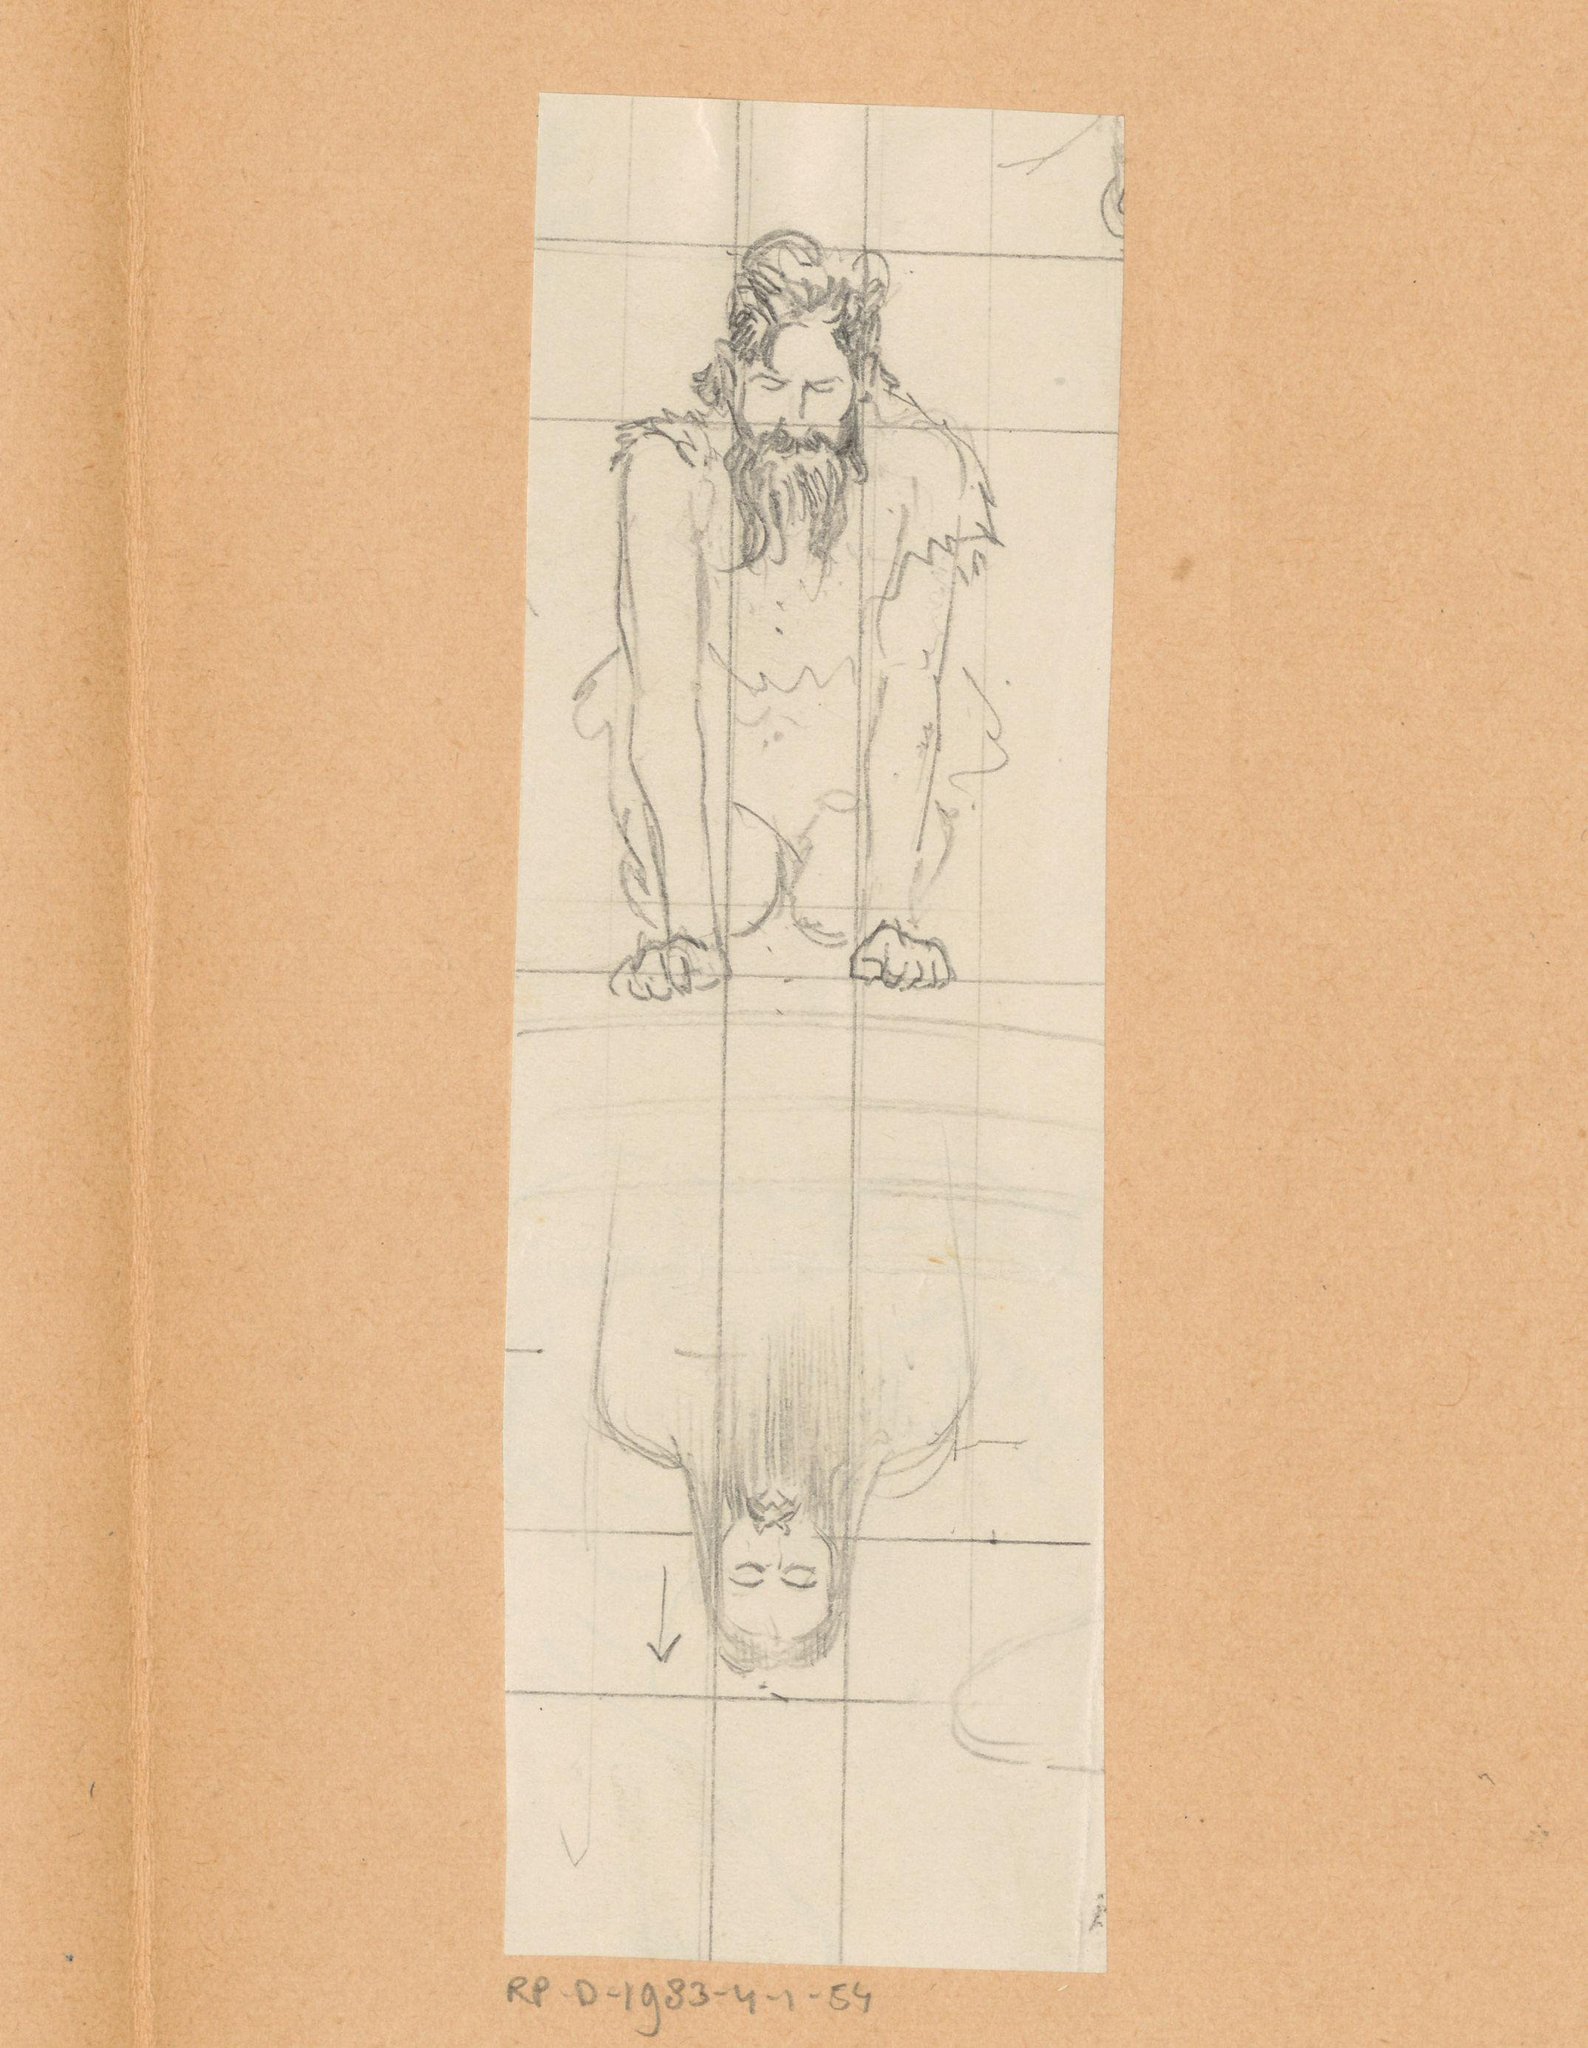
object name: bookplate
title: Ontwerptekening voor ex libris van Theo Bosloper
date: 1930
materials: paper, pencil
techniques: drawing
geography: netherlands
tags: youth, adolescent, old man, kneeling figure, reflection (light in general)